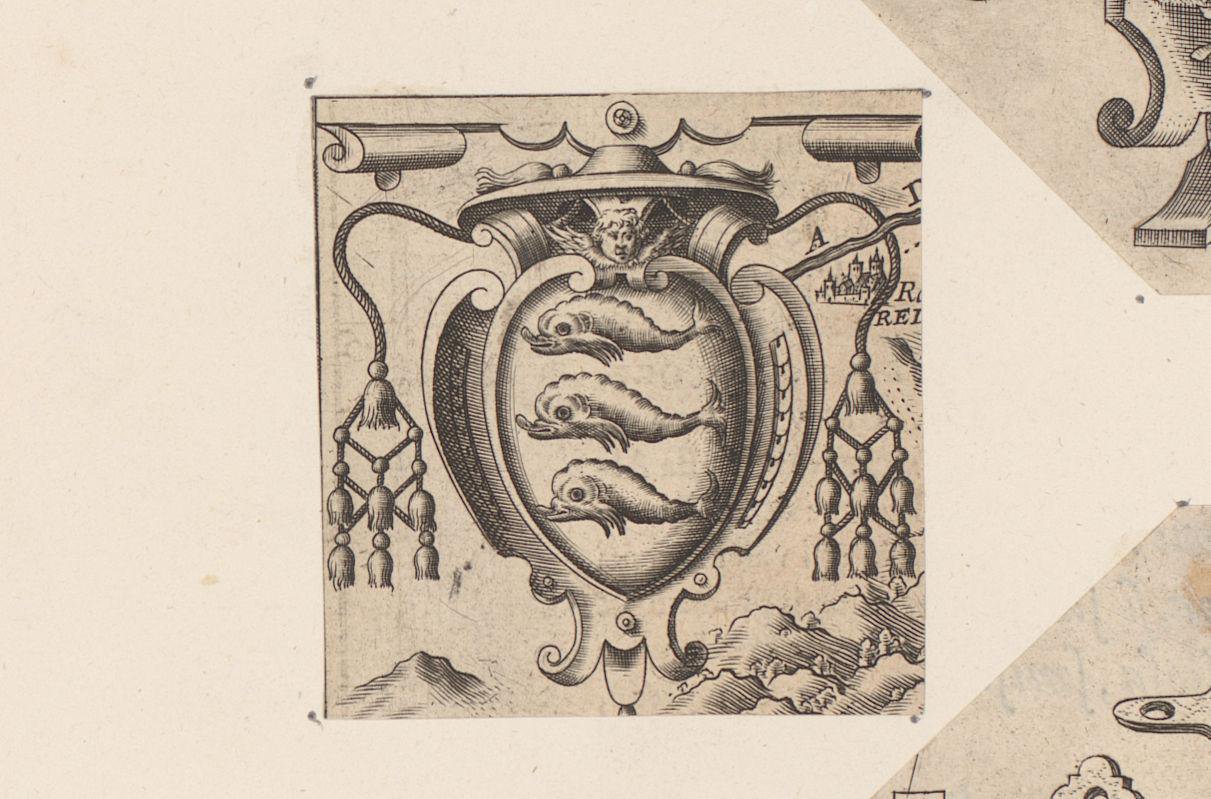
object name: album leaf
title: Cartouche met wapenschild waarop drie dolfijnen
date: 1608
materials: paper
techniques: engraving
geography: antwerp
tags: ornament ~ cartouche, armorial bearing, heraldry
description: Cartouche met wapenschild waarop drie dolfijnen (mogelijk van Joannes Delphinus aan wie de kaart werd opgedragen). Midden boven een cherubijn. Het betreft een fragment van een kaart van Bologna en Vicenza. De prent maakt deel uit van een album.